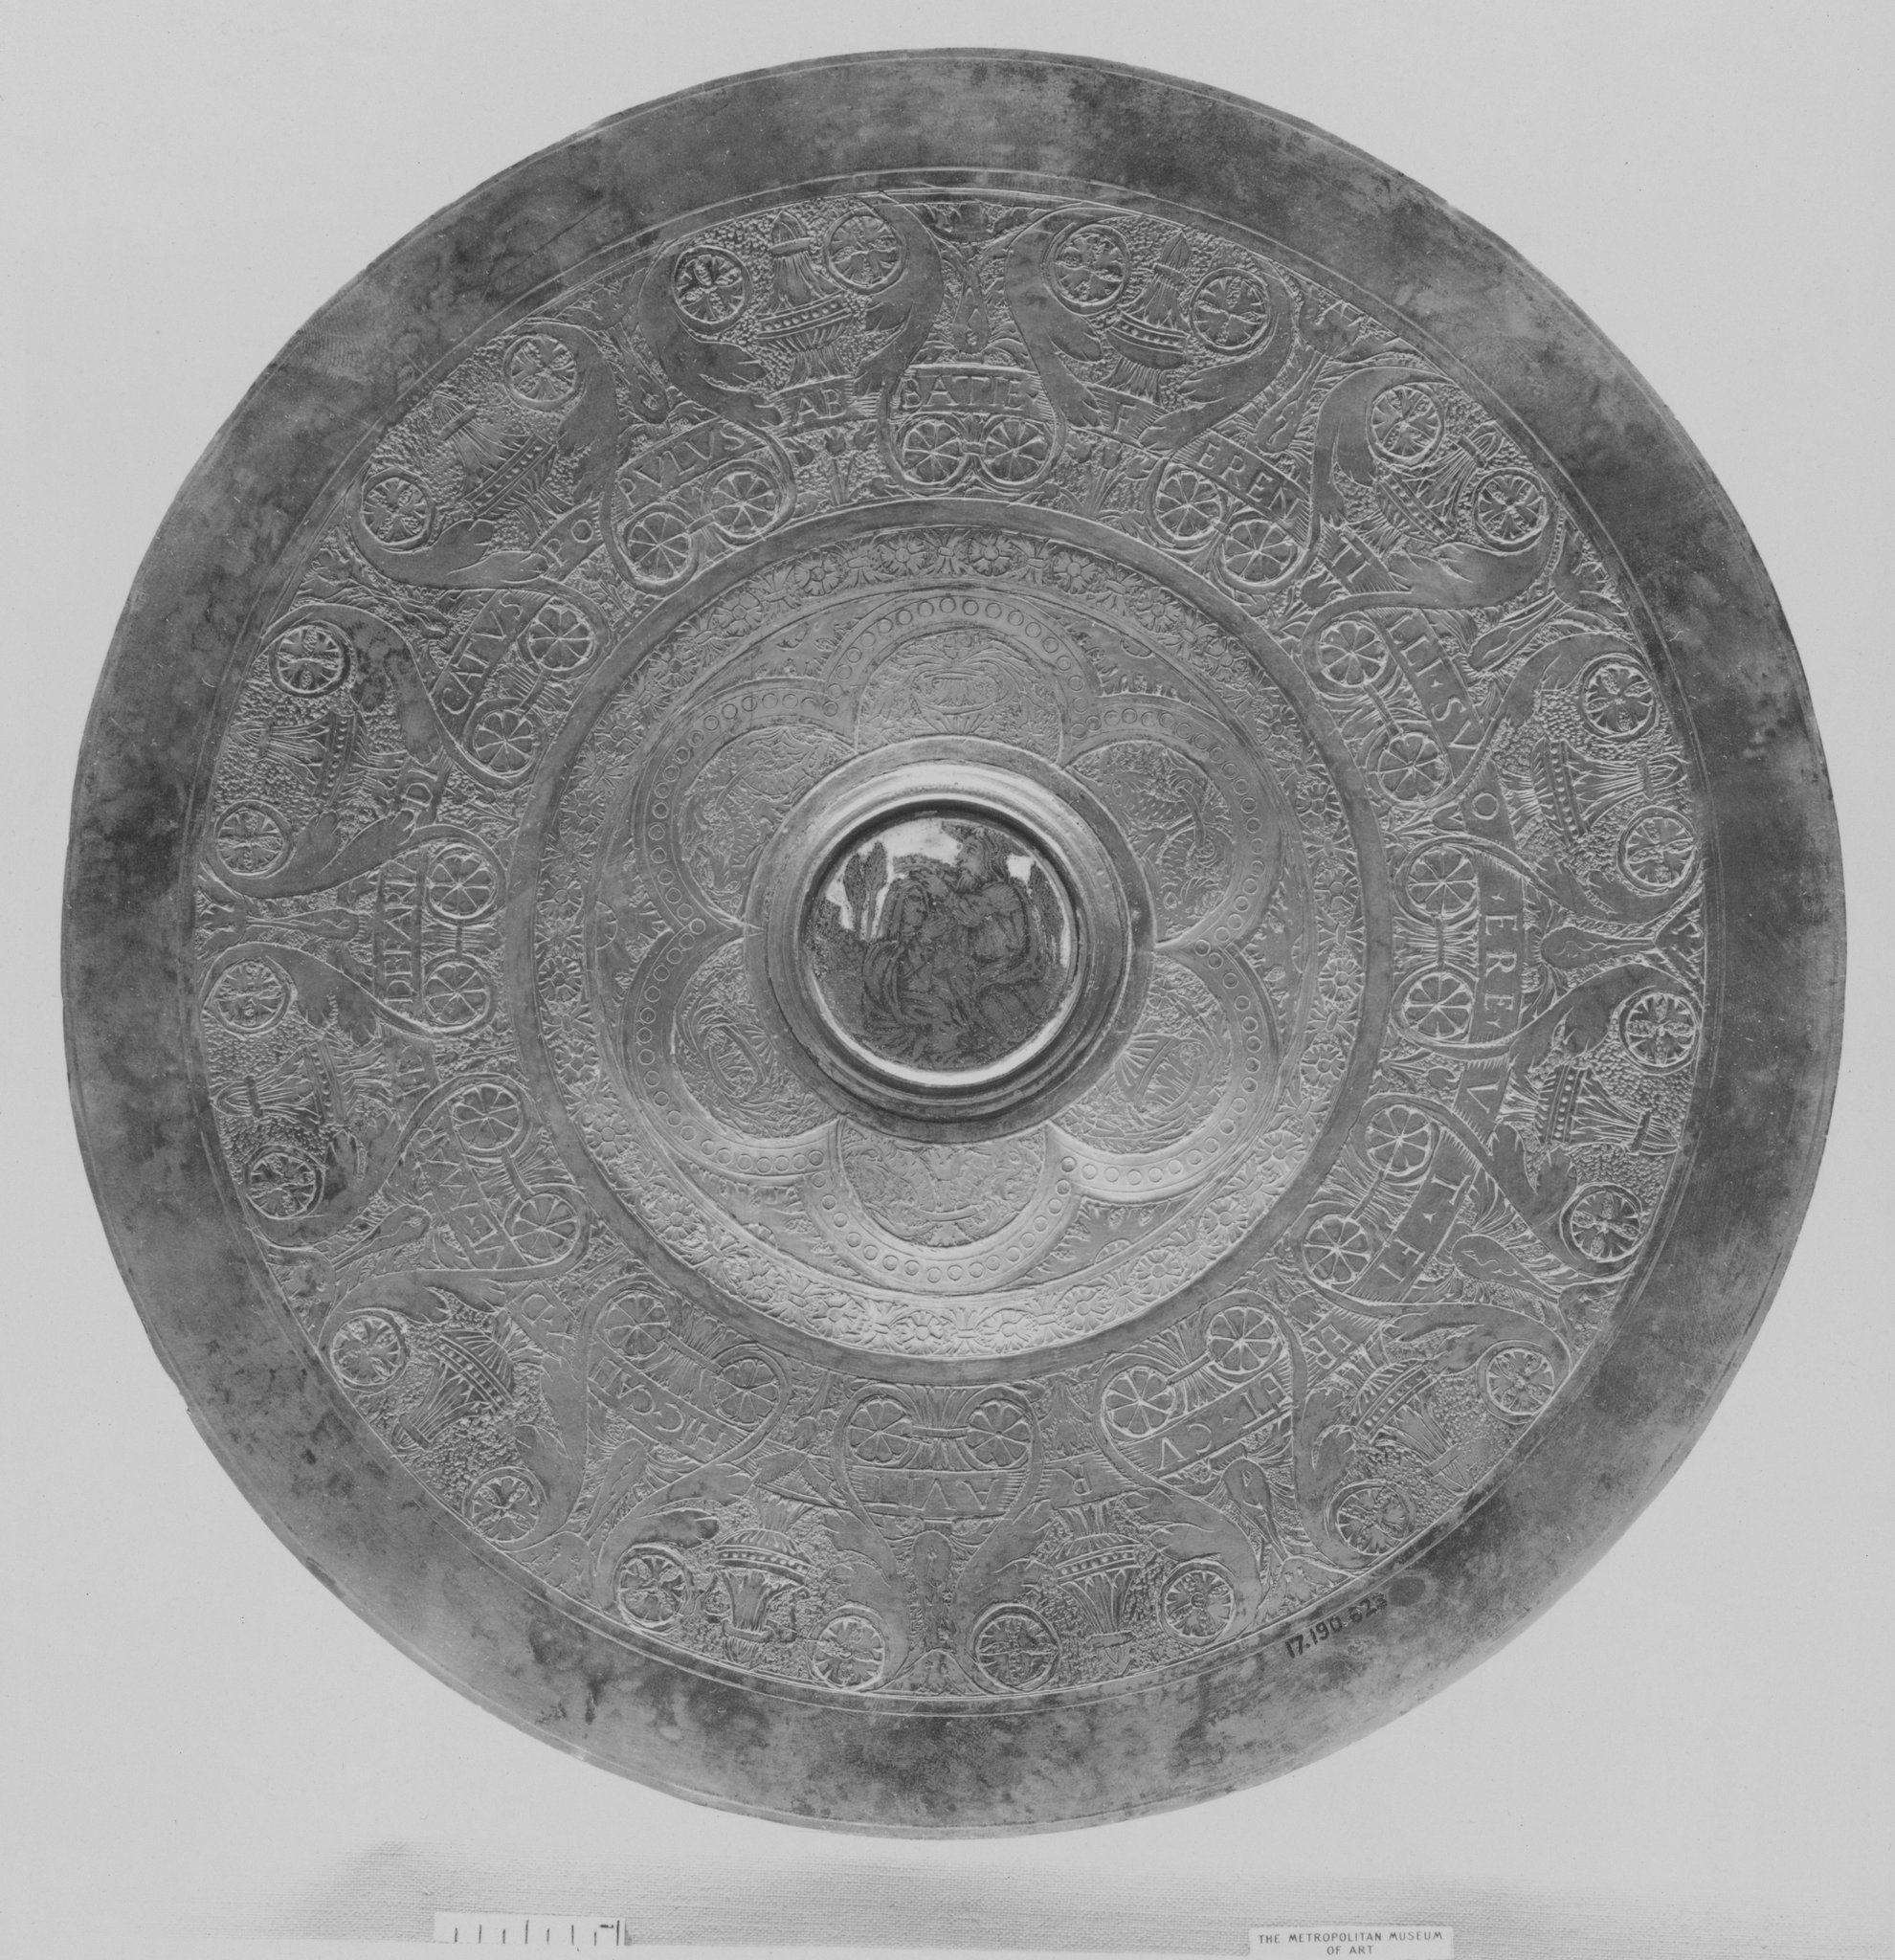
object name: paten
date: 1467-1500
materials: enamel, copper gilt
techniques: enamel